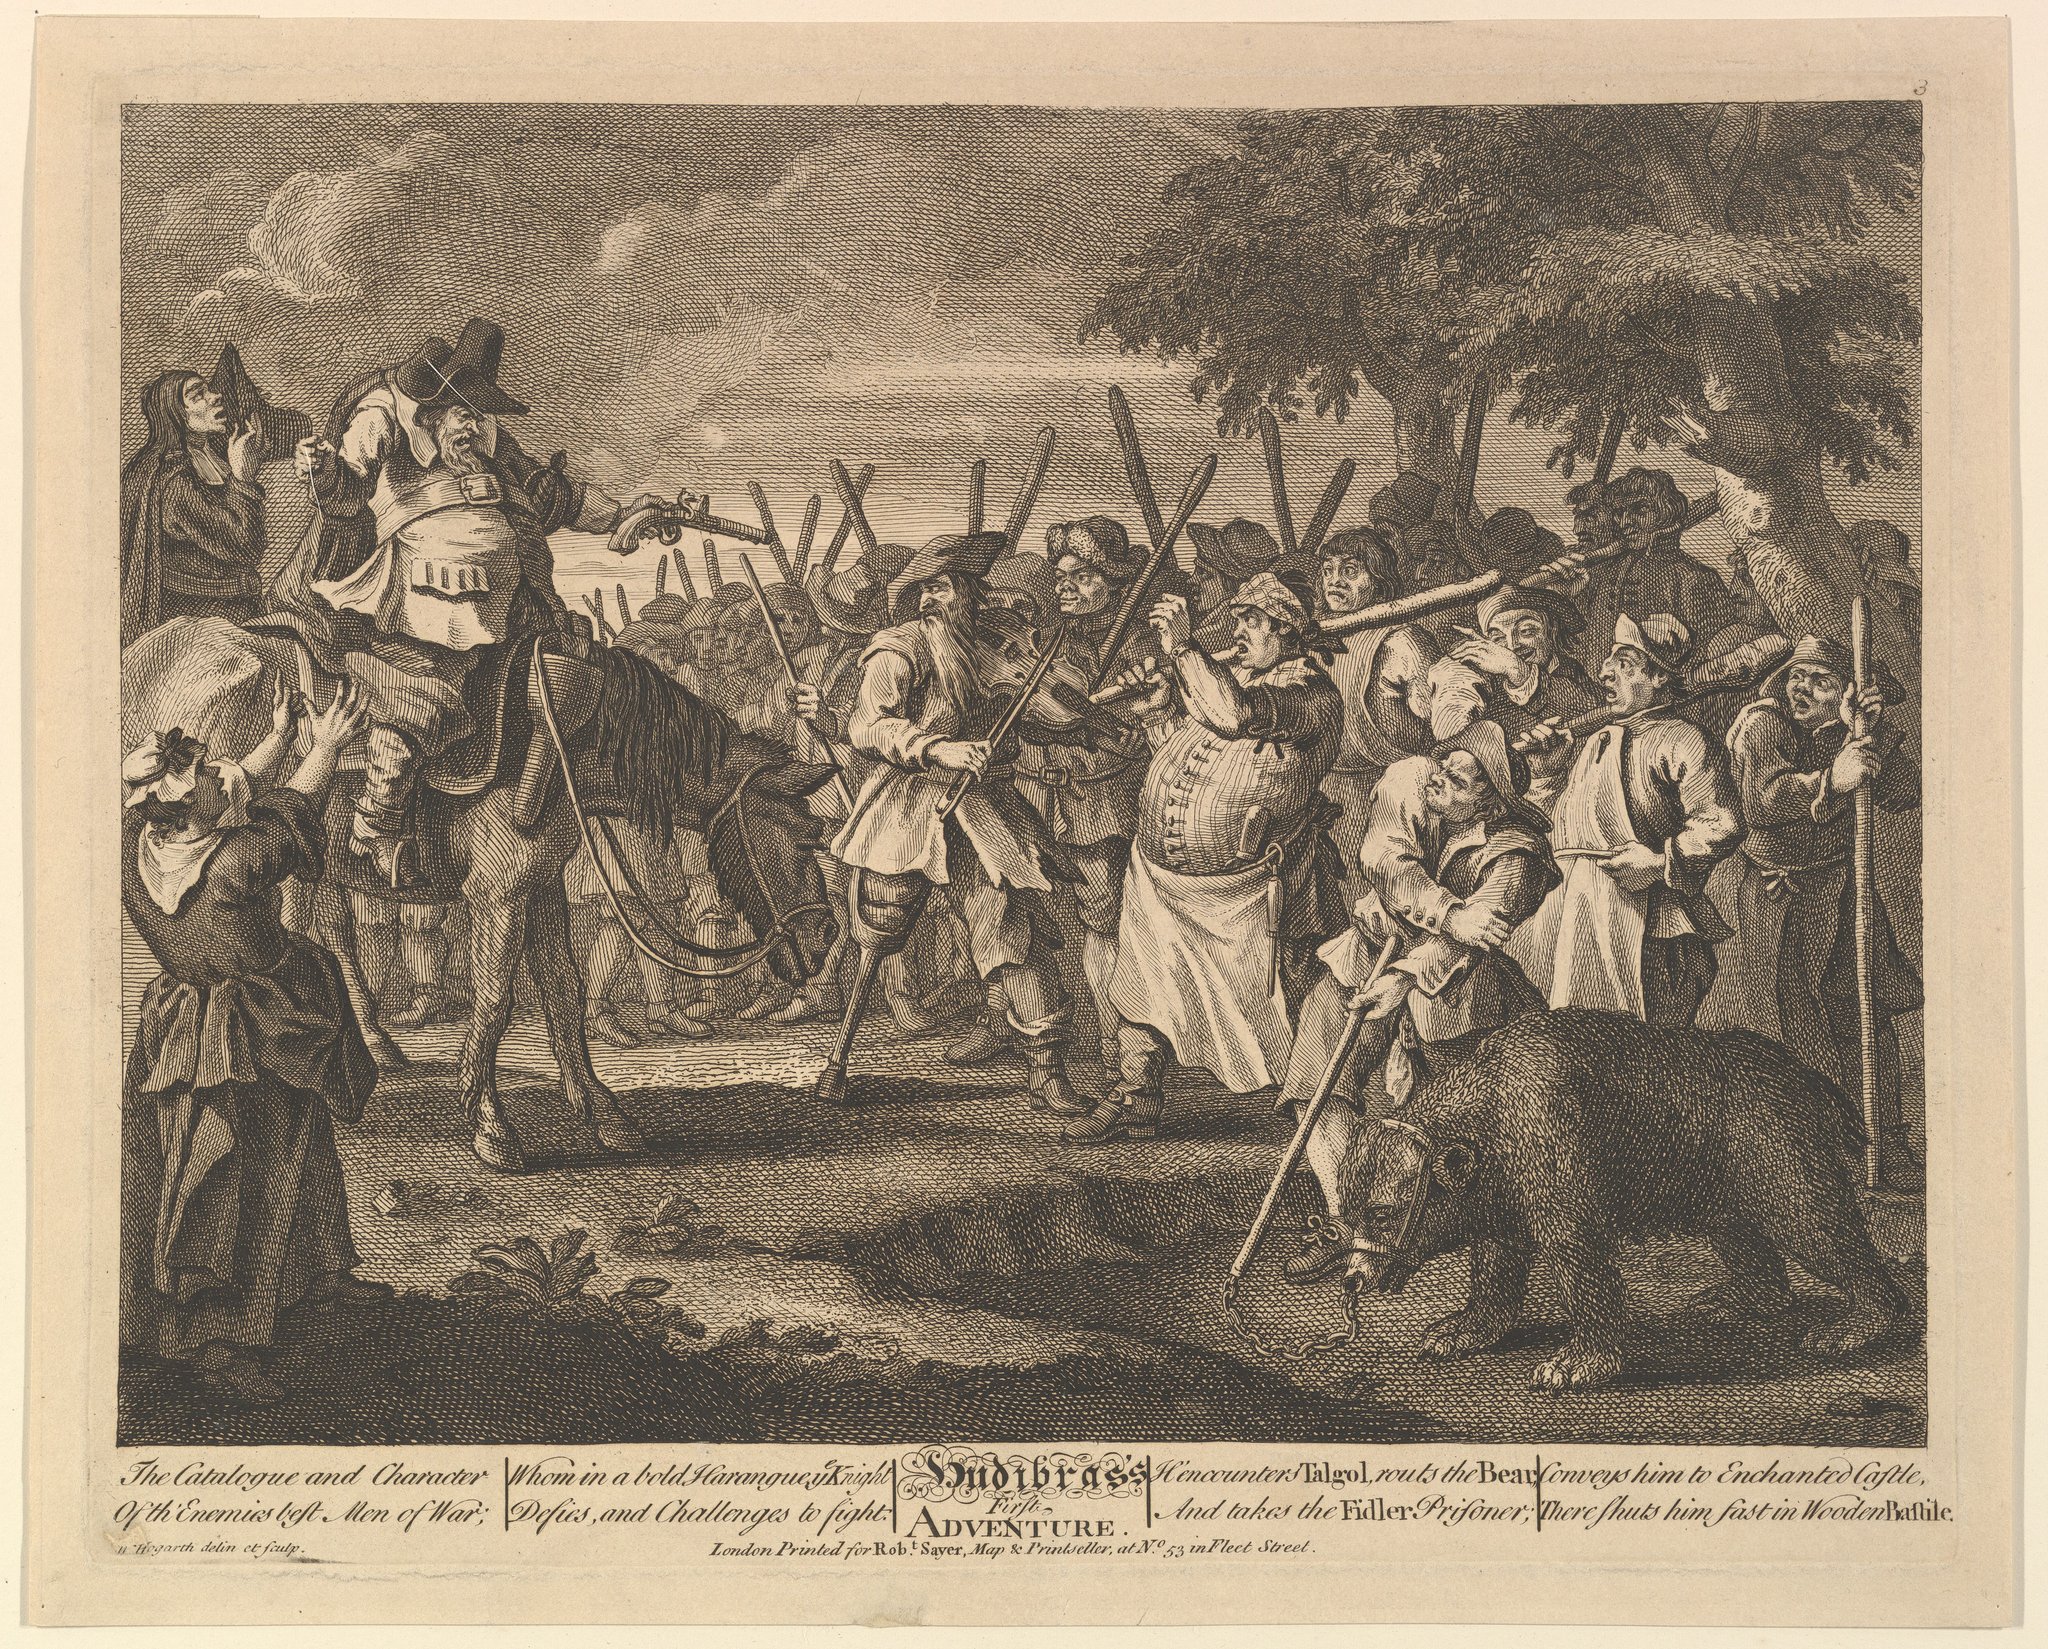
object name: print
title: Hudibras's First Adventure (Twelve Large Illustrations for Samuel Butler's Hudibras, Plate 3)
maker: william hogarth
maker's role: artist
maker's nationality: british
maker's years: 1697-1764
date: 1725-1768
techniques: engraving, etching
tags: bears,firearms,men,women,horses